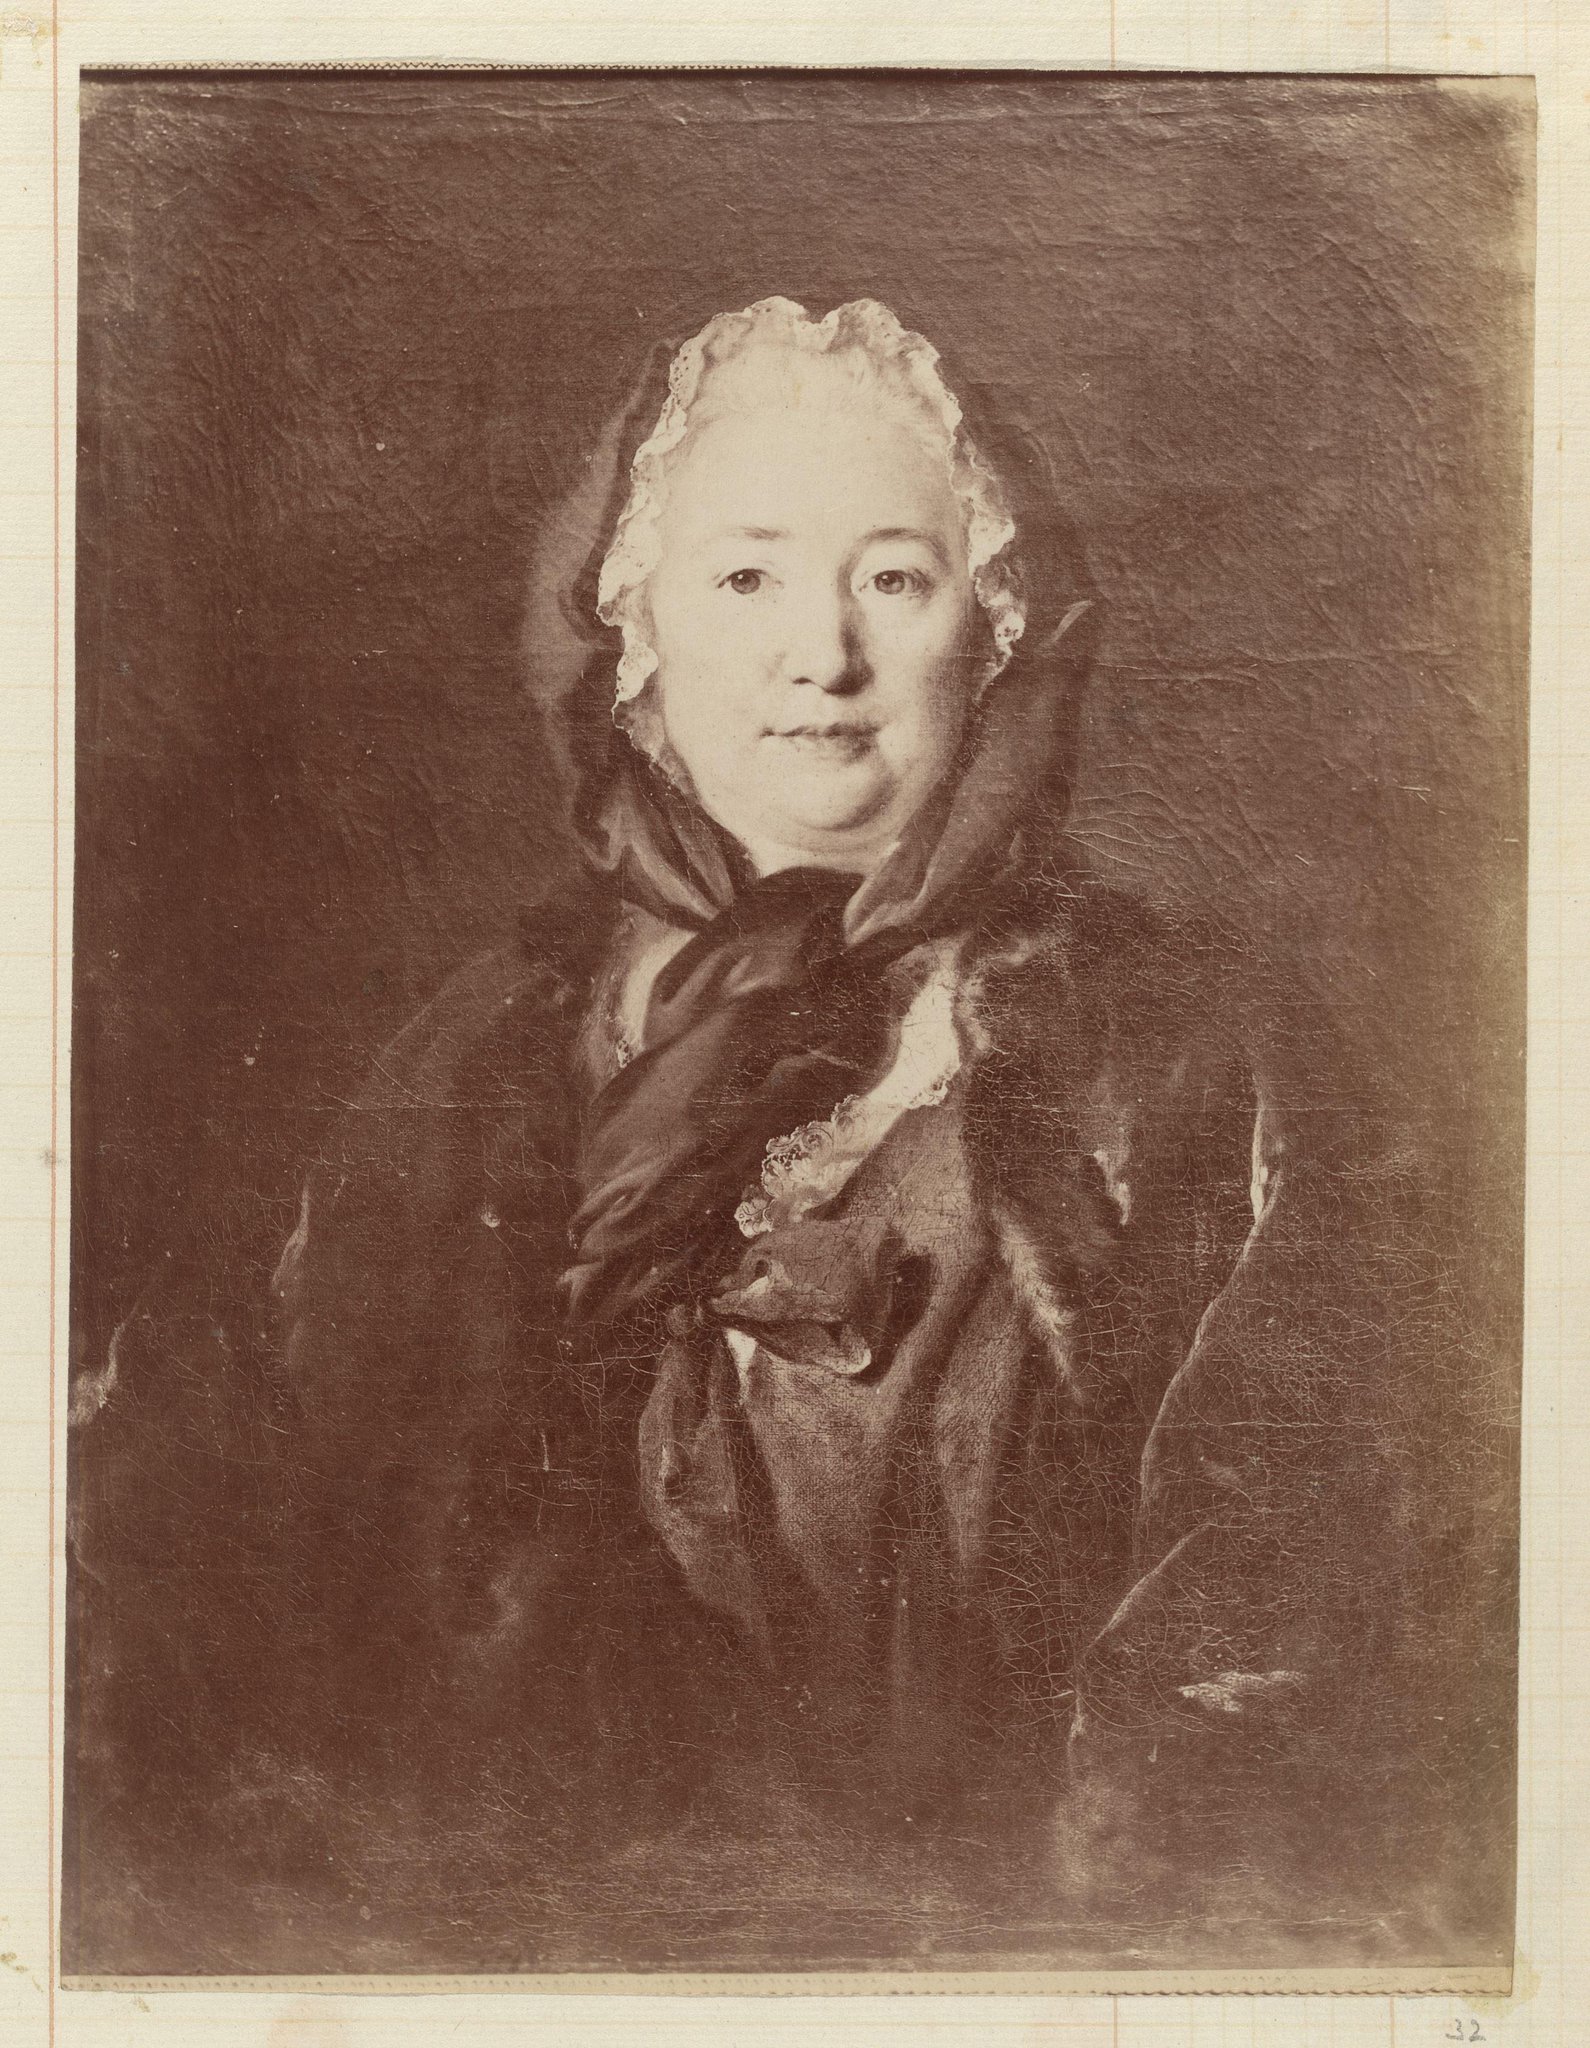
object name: photograph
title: Fotoreproductie van een schilderij, voorstellend een portret van een vrouw met een muts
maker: Anonymous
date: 1880-1900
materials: paper, photographic support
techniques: albumen print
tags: old woman